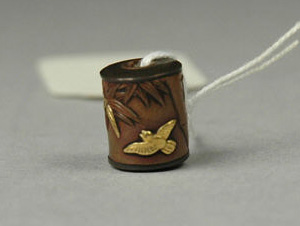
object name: ojime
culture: japanese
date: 1801-1900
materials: bamboo, bronze, gold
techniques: inlay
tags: birds,leaves